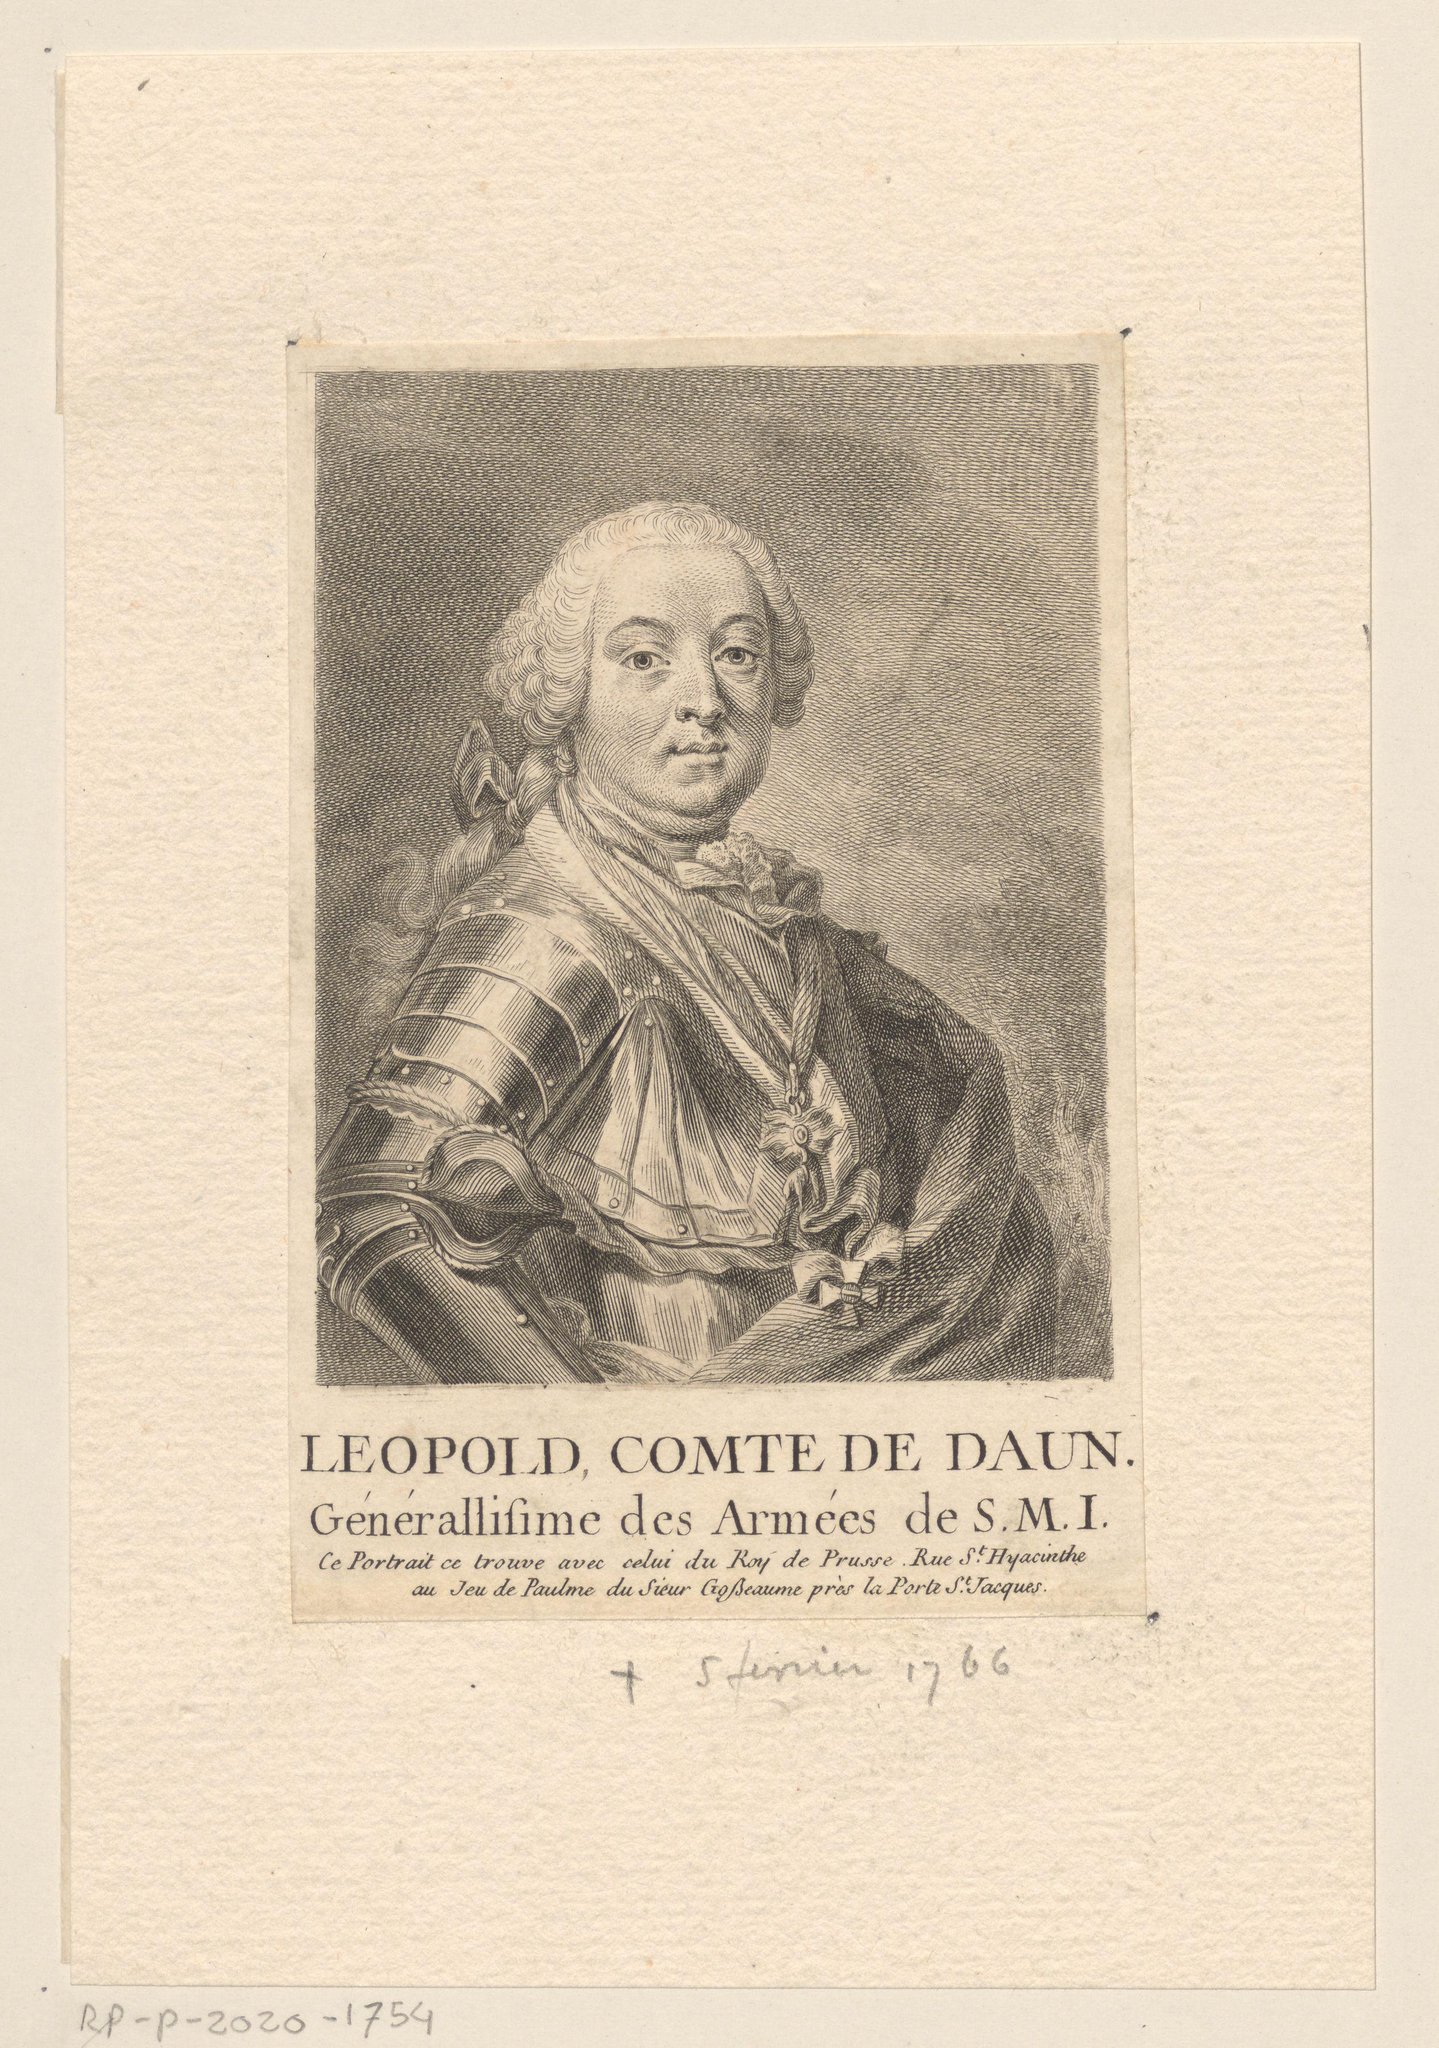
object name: print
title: Portret van Leopold Joseph von Daun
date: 1759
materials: paper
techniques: engraving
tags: vienna, commander-in-chief, general, marshal, historical persons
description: Prent wordt genoemd in: Mercure de France, dédié au roi. Parijs: Daniel Hugues Chaubert et al., 1659, dl. 1.